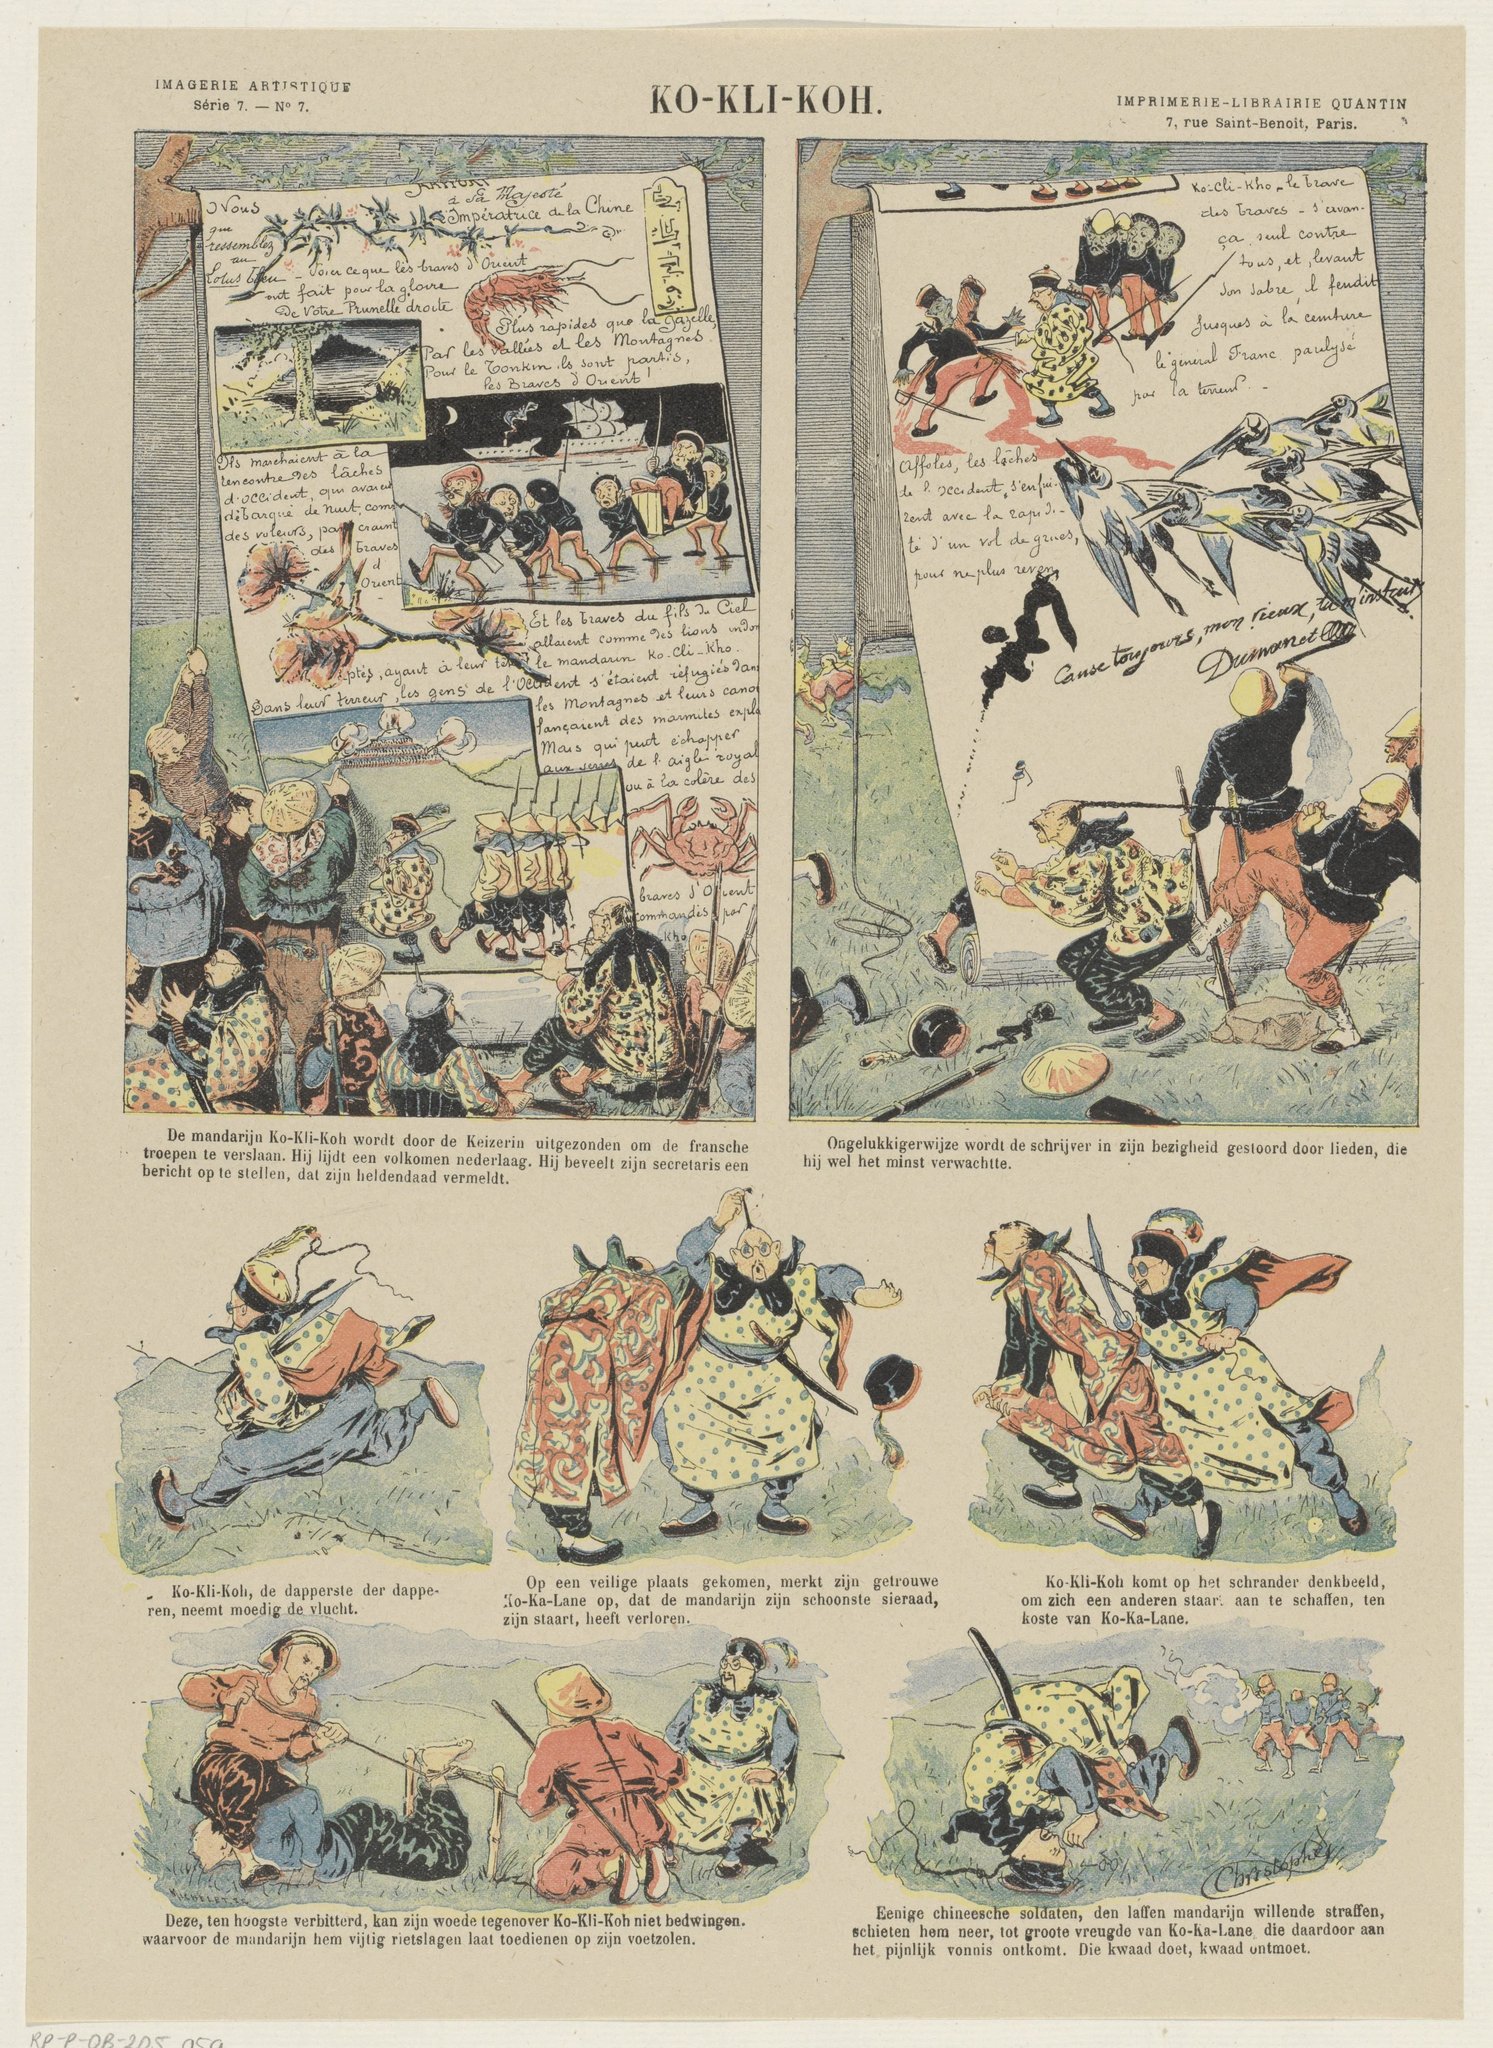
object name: popular print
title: Ko-Kli-Koh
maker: albert quantin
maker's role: printer, publisher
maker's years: 1850-1933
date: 1876-1890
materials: paper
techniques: lithograph, letterpress printing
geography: paris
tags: chinese, coward, tales and fairy tales, the soldier; the soldier's life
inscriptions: collector's mark: Lugt 2760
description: Blad met 7 voorstellingen van de Chinese lafaard Ko-Kli-Ko. Onder elke voorstelling een onderschrift. Genummerd linksboven: Série 7. - No. 7.